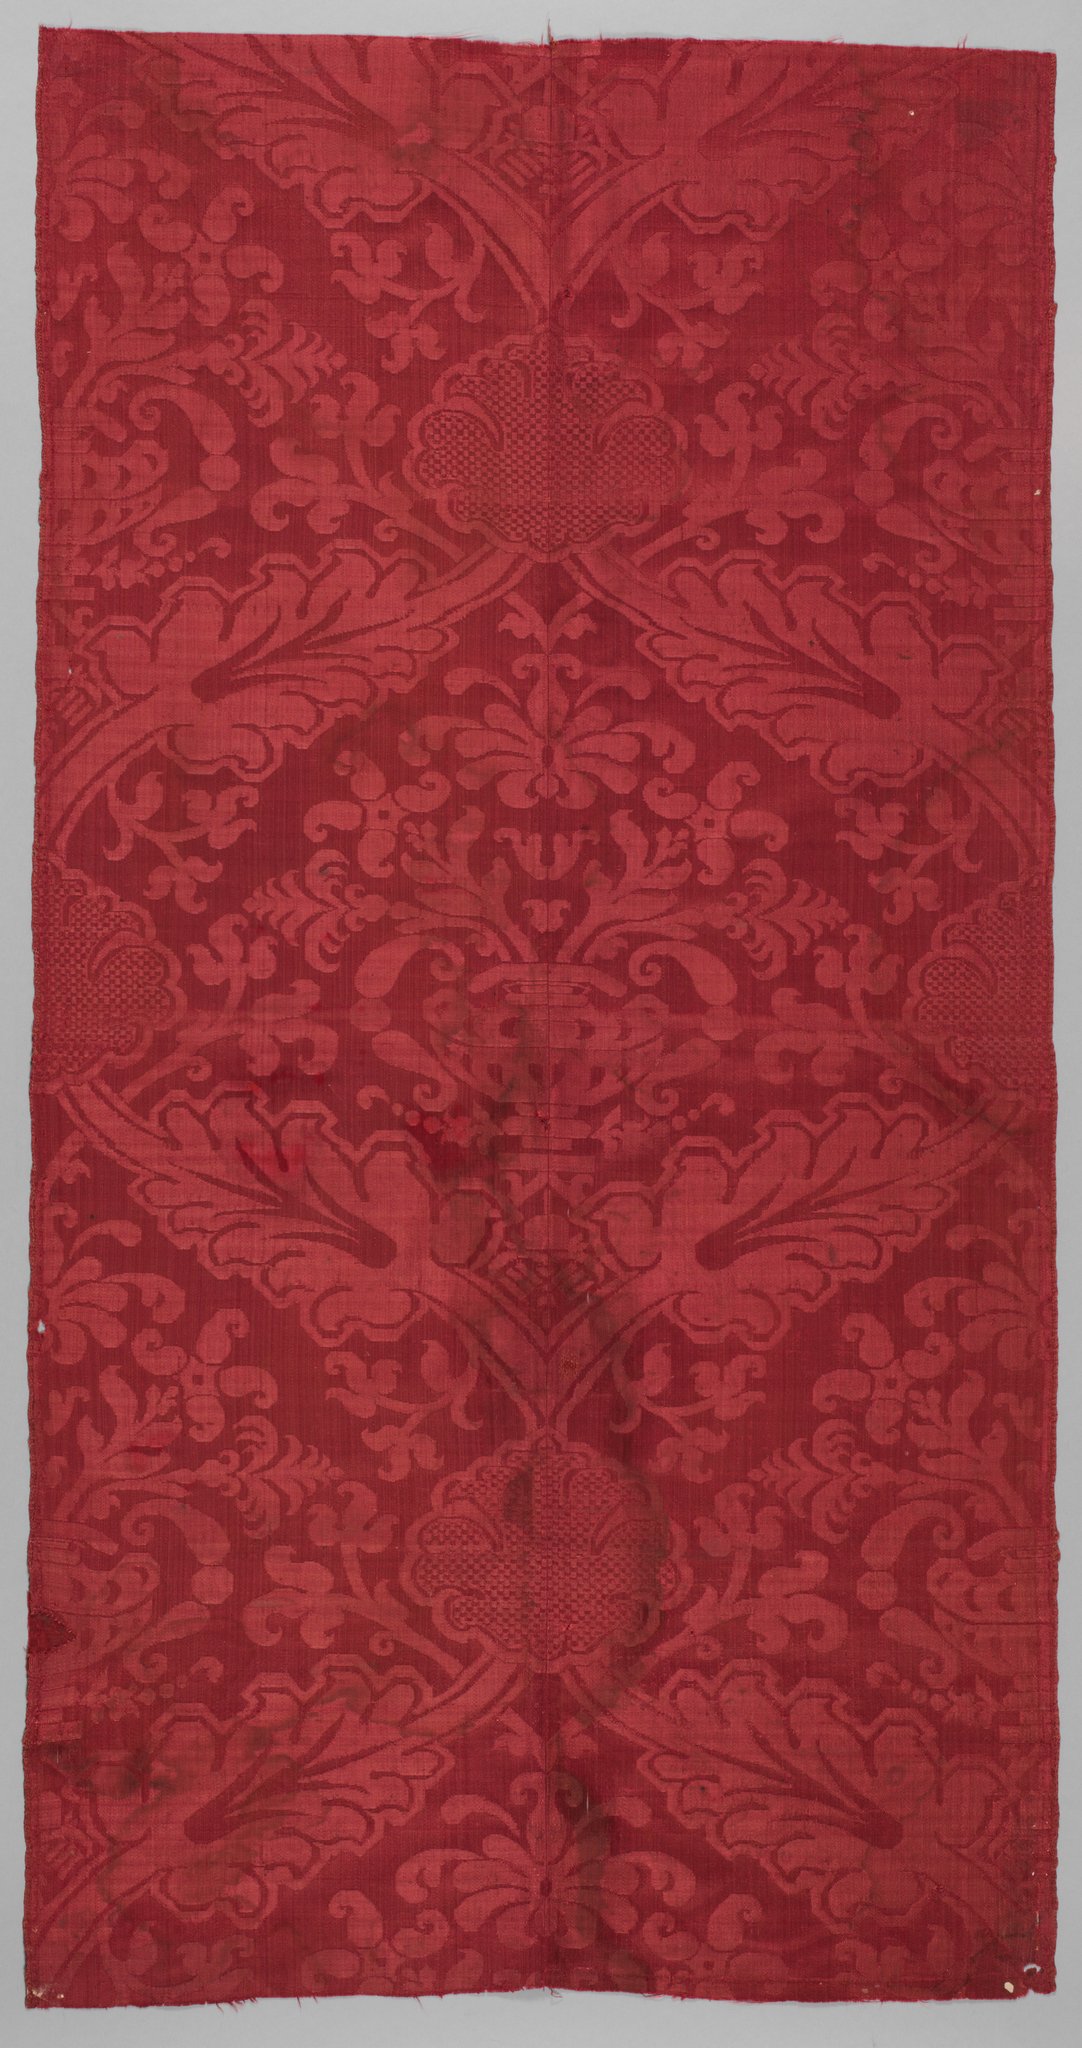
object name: piece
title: Crimson Silk Damask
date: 1600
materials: silk